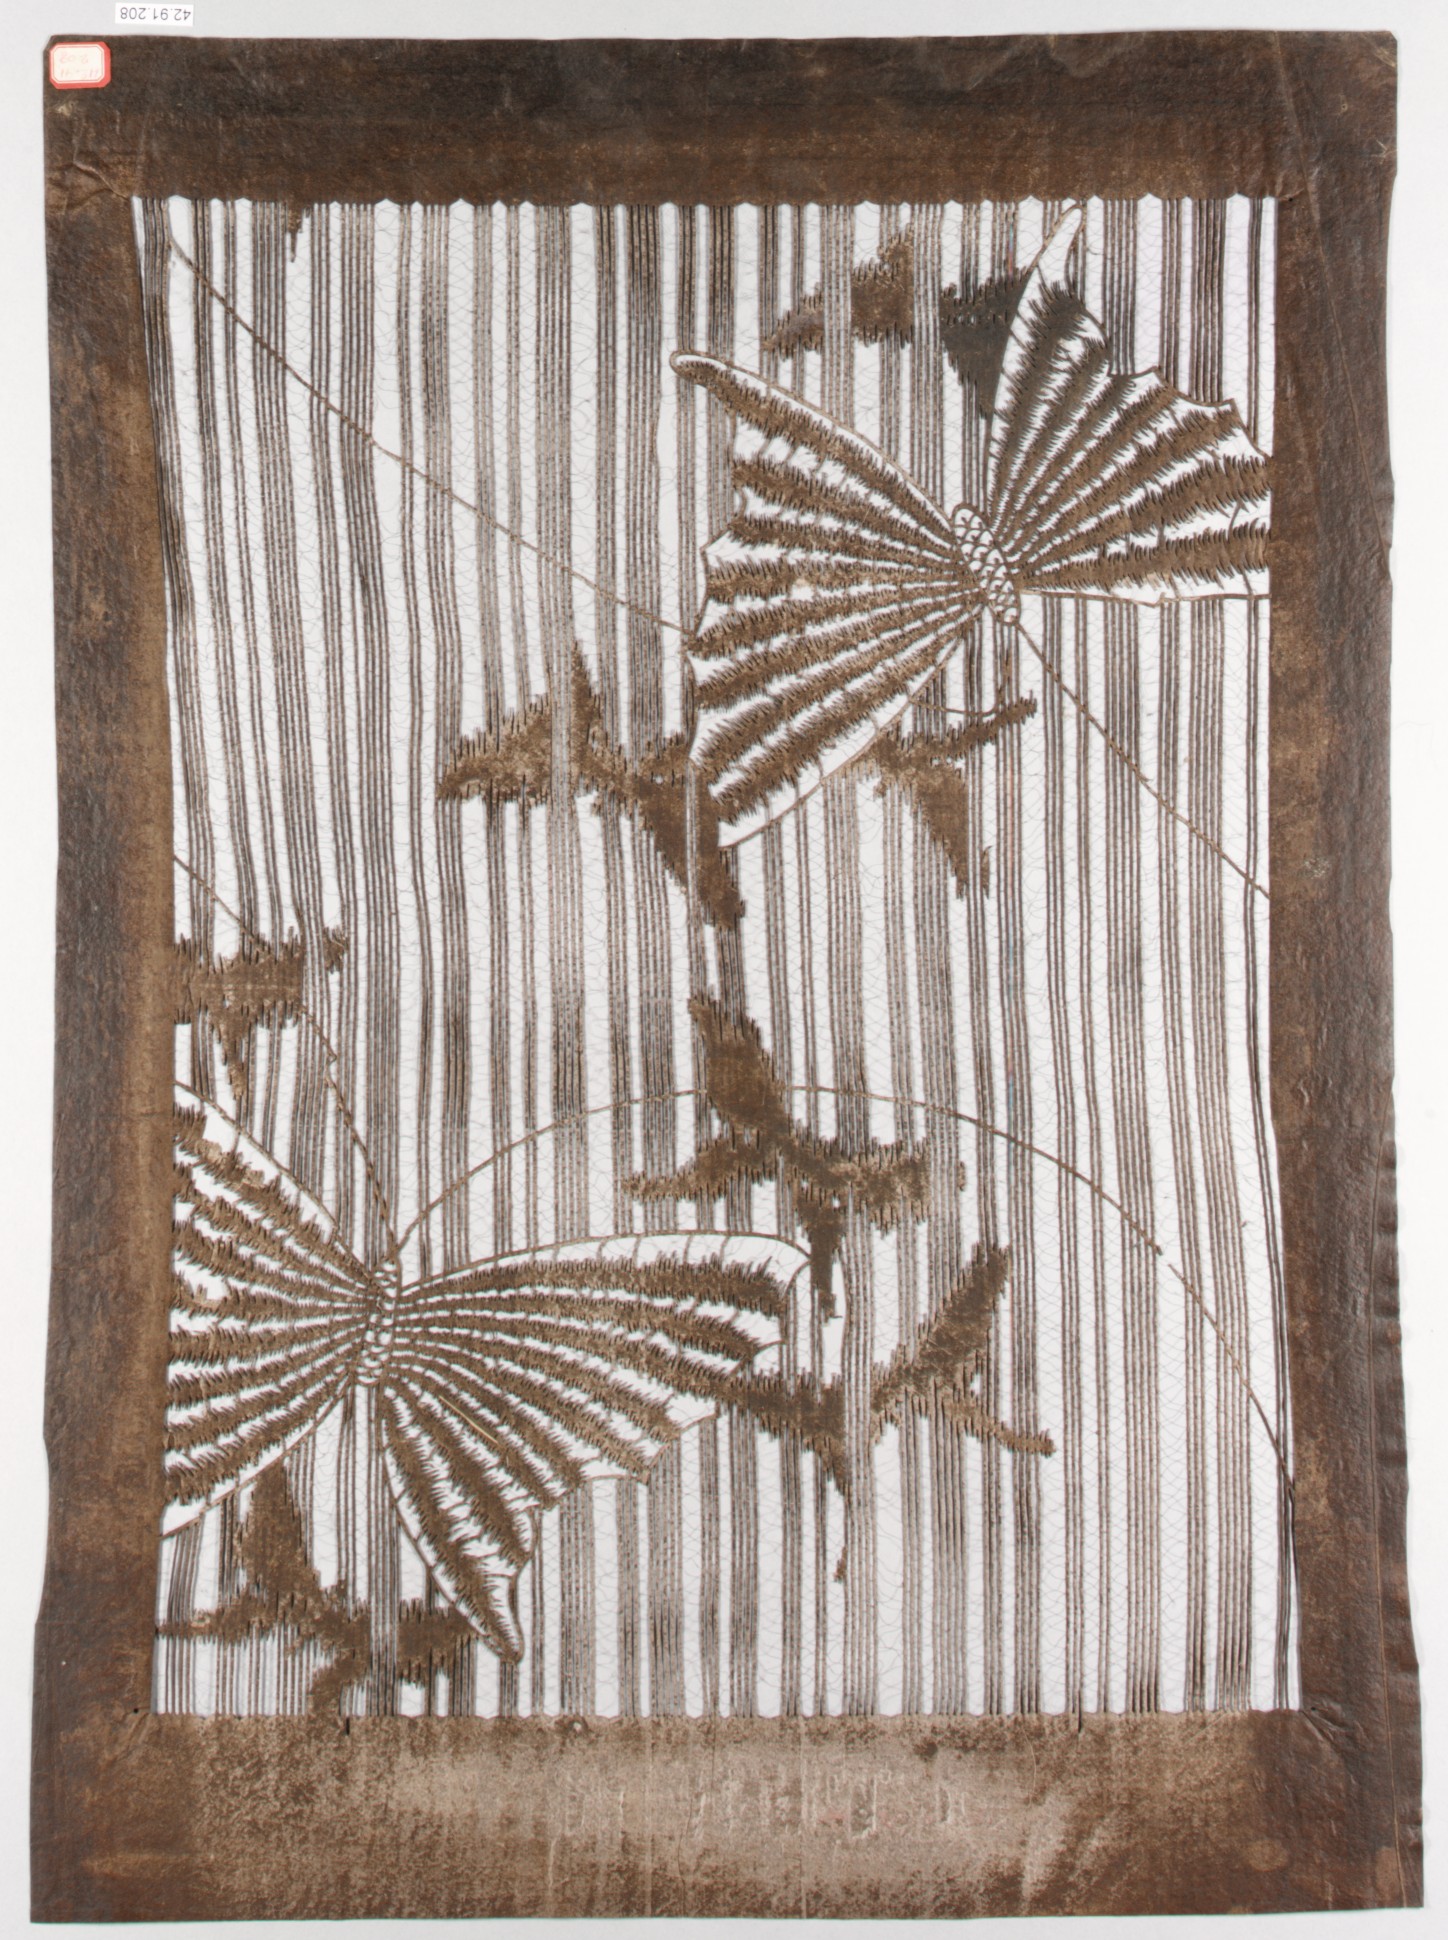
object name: stencil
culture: japanese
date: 1801-1900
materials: paper, silk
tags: butterflies